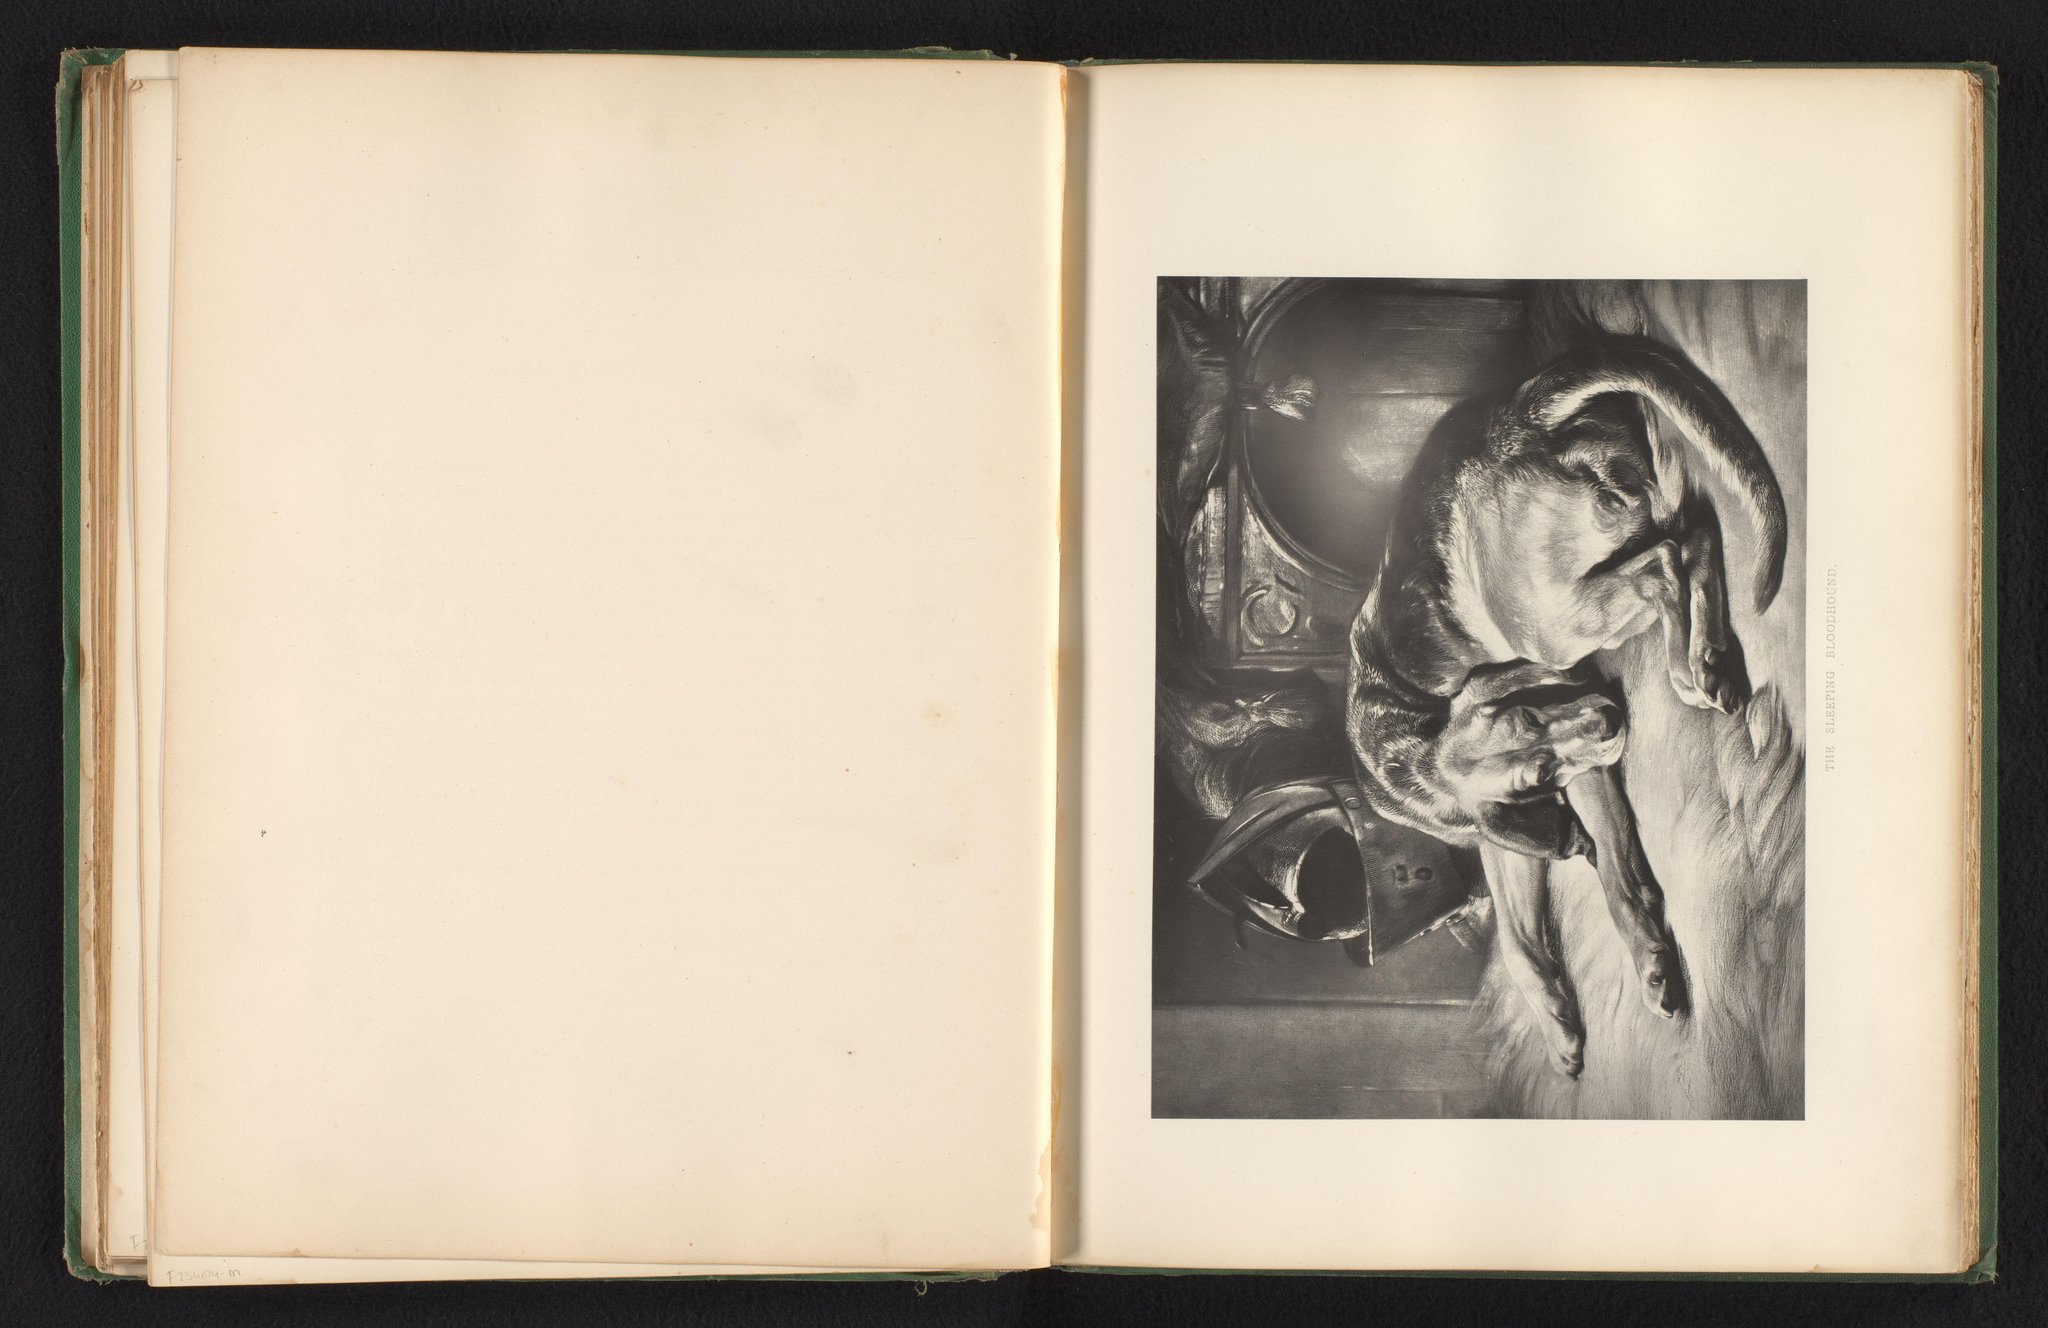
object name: page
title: Reproductie van een prent naar een schilderij van een slapende bloedhond door Edwin Landseer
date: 1878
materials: paper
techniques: woodburytype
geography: london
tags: dog